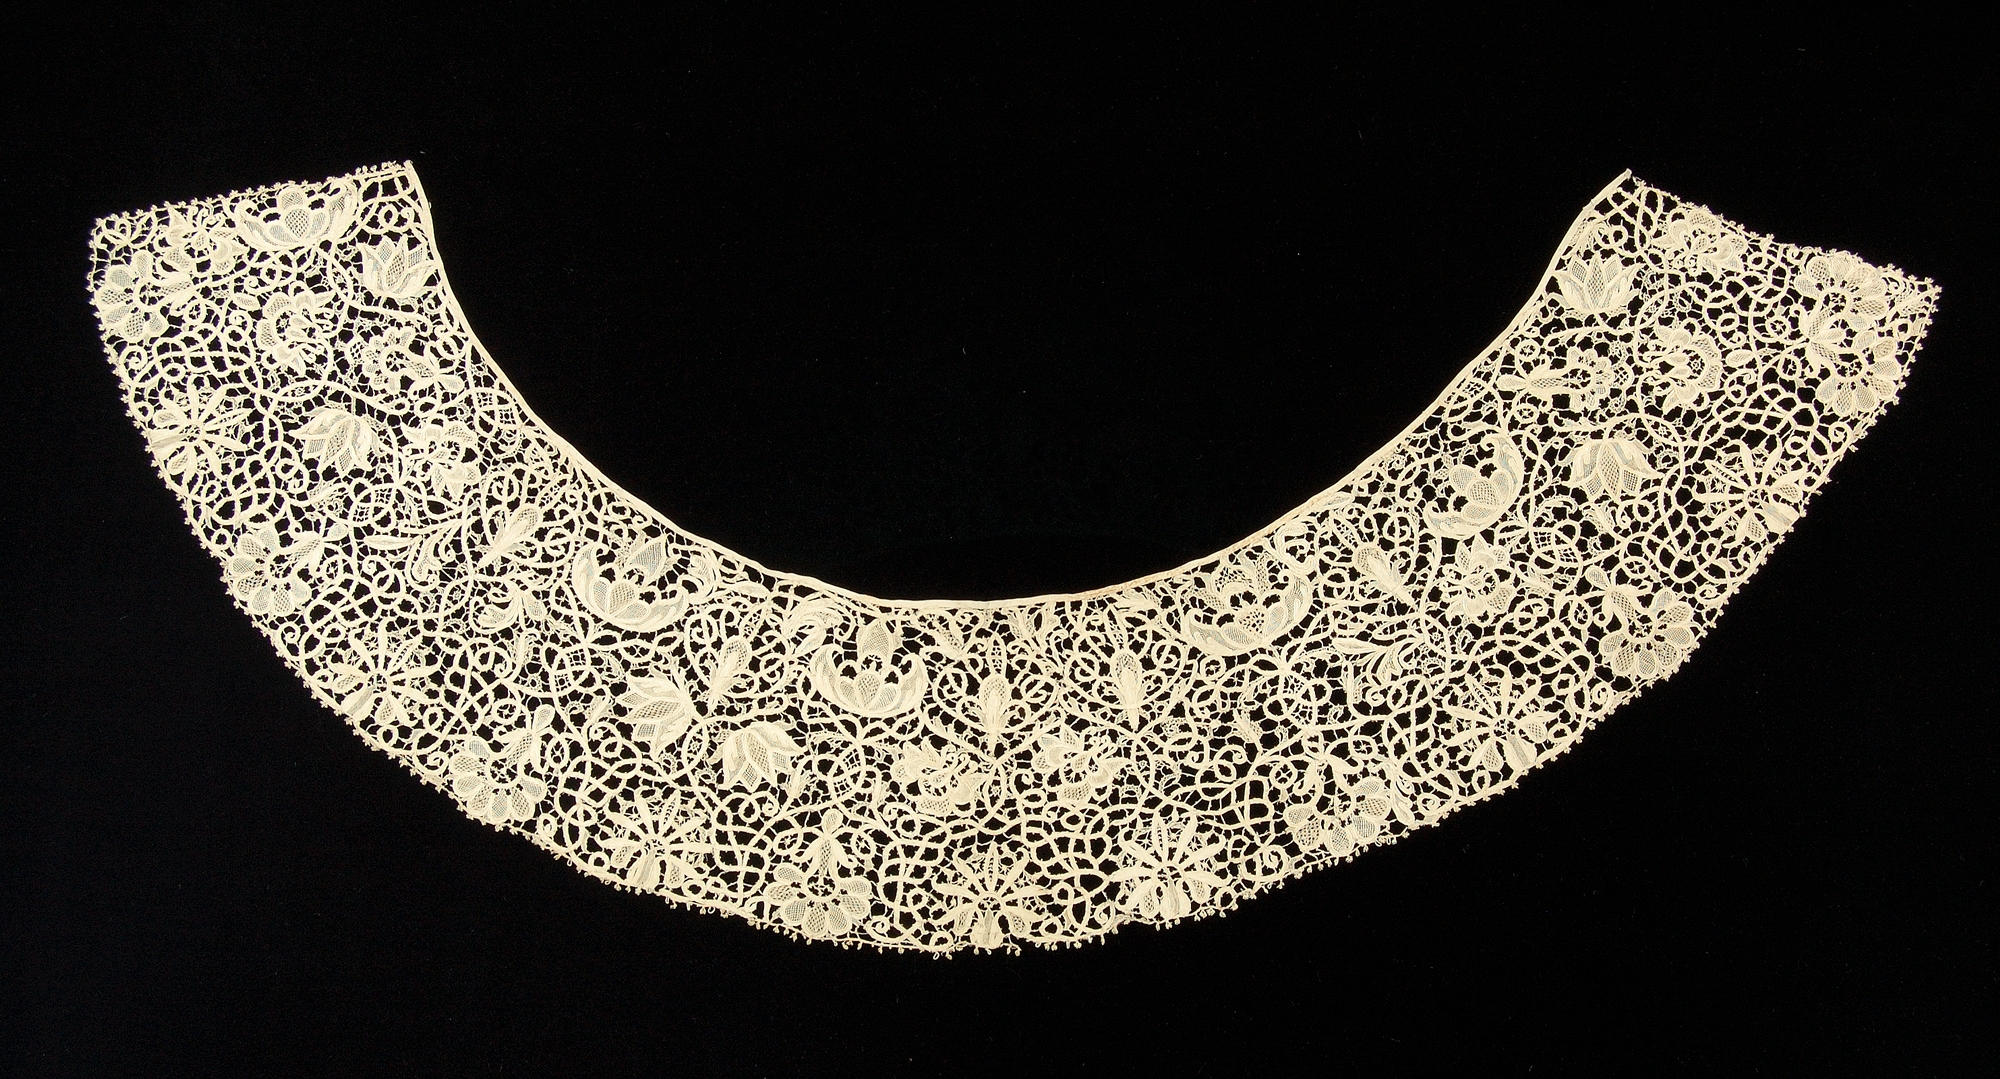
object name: collar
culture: italian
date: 1667-1700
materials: linen